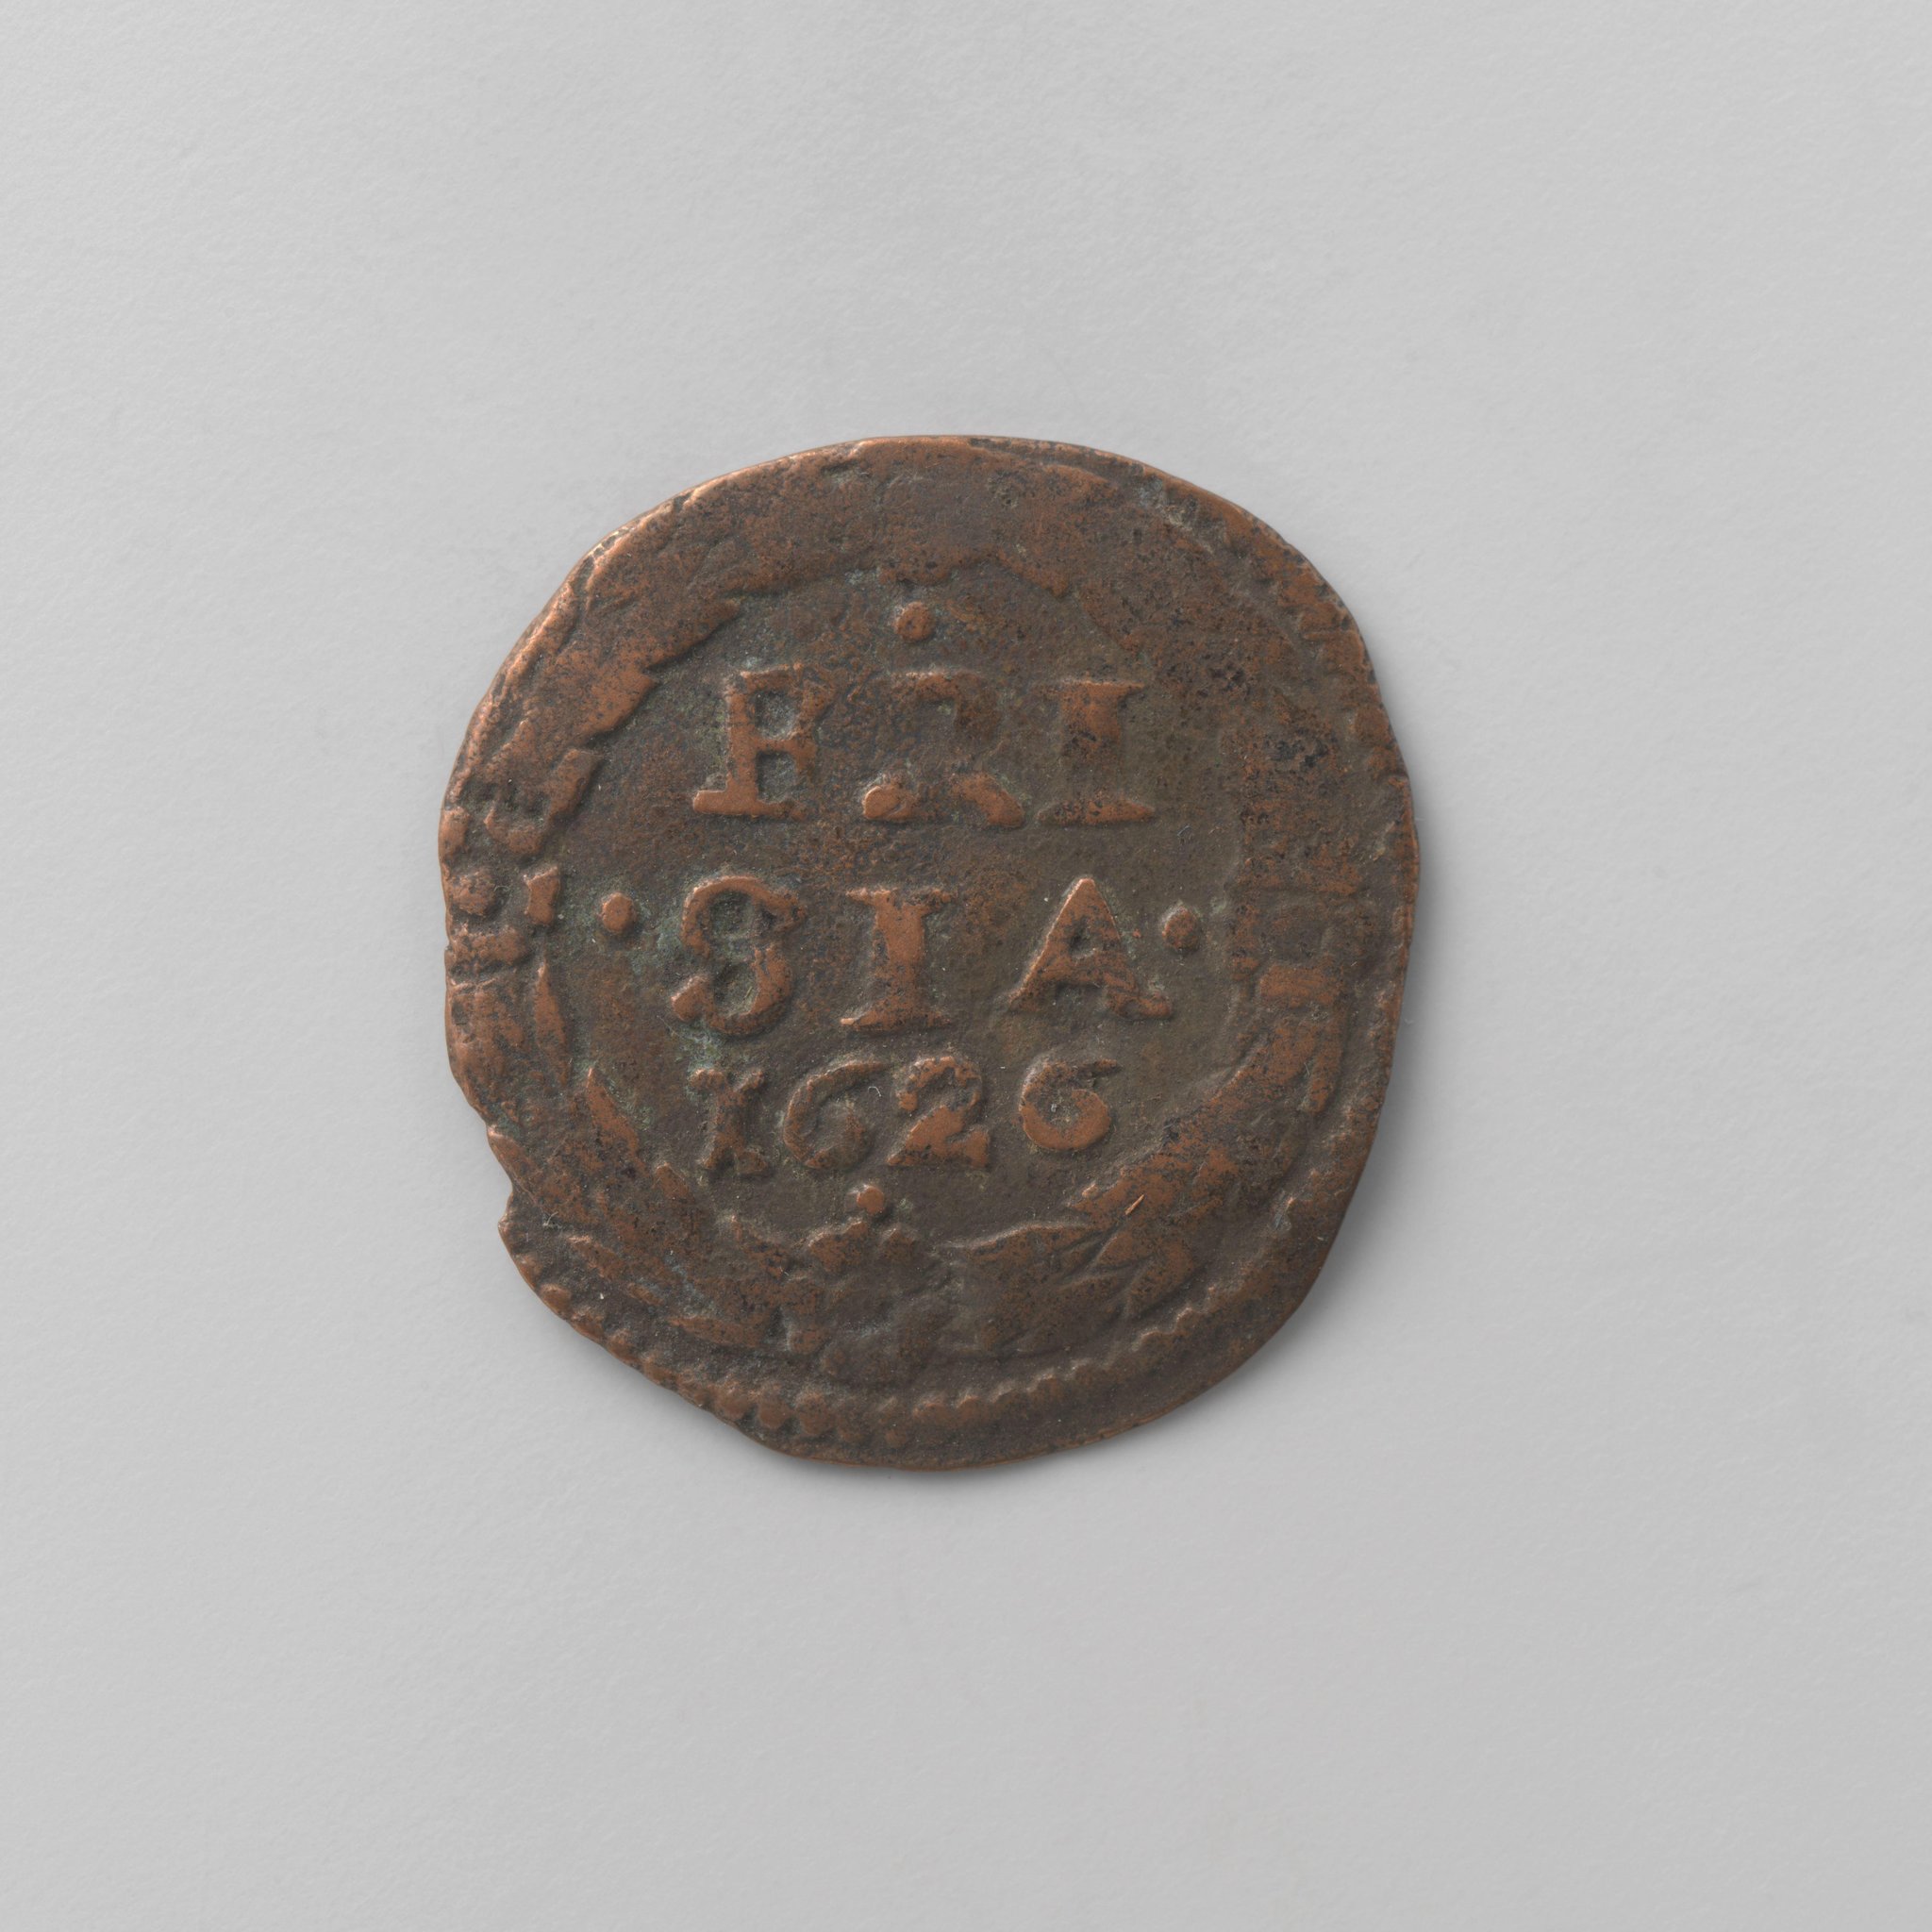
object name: coin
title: Duit van Friesland, 1626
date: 1626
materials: copper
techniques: striking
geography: leeuwarden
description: Koperen munt. Voorzijde: gekroond en versierd ovaal wapenschild van Friesland. Keerzijde: in een bladerkrans opschrift in twee regels, waaronder jaartal.